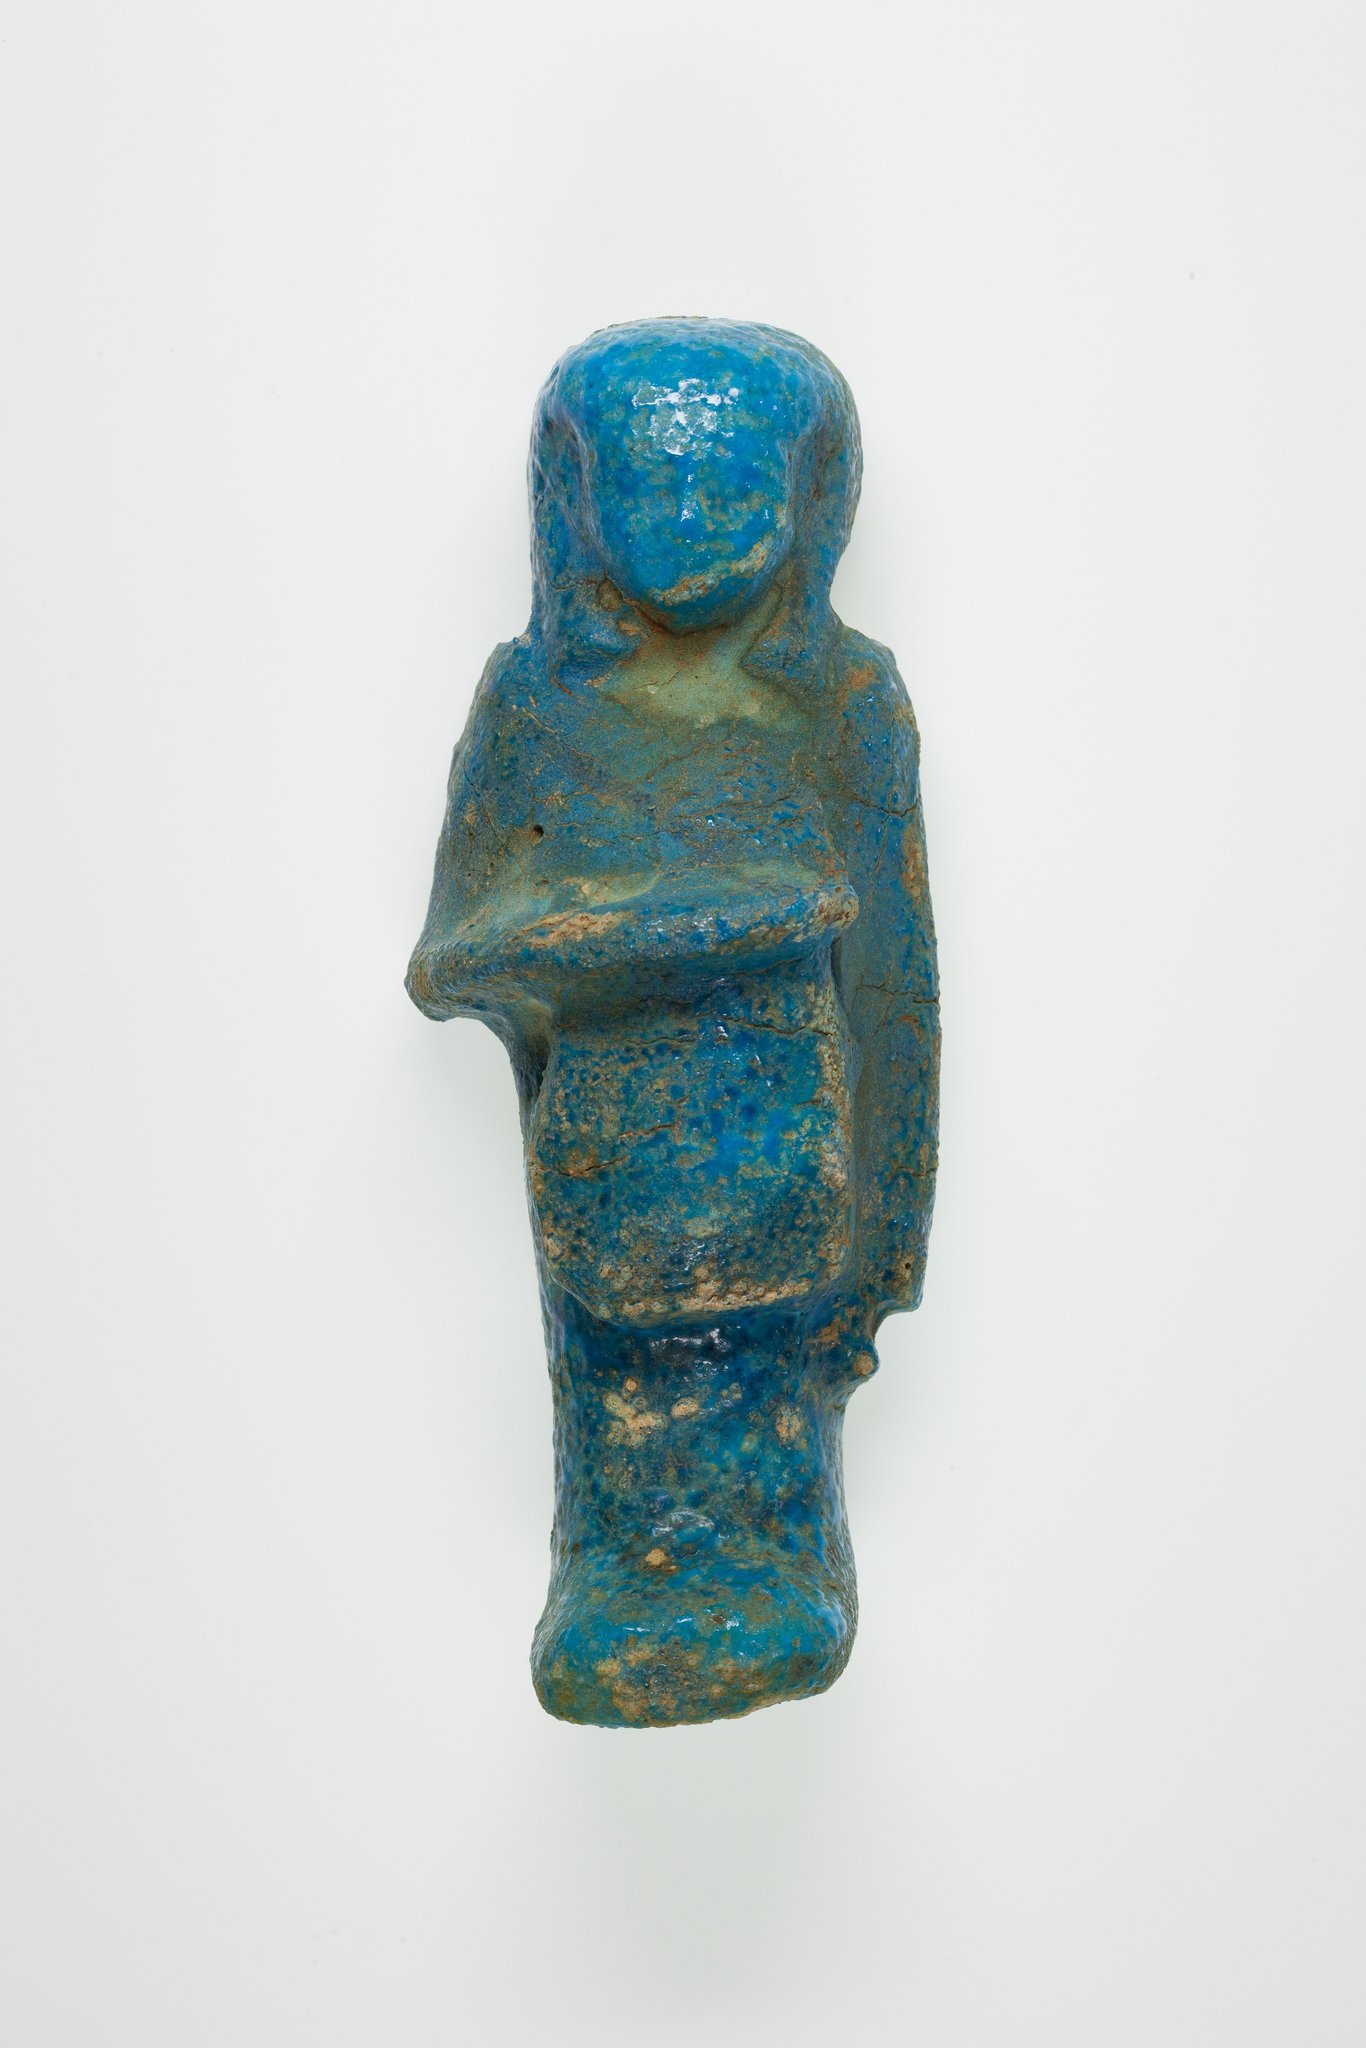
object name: overseer shabti, henettawy c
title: Overseer Shabti of Henettawy (C), Daughter of Isetemkheb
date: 990-970 BCE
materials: faience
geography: egypt